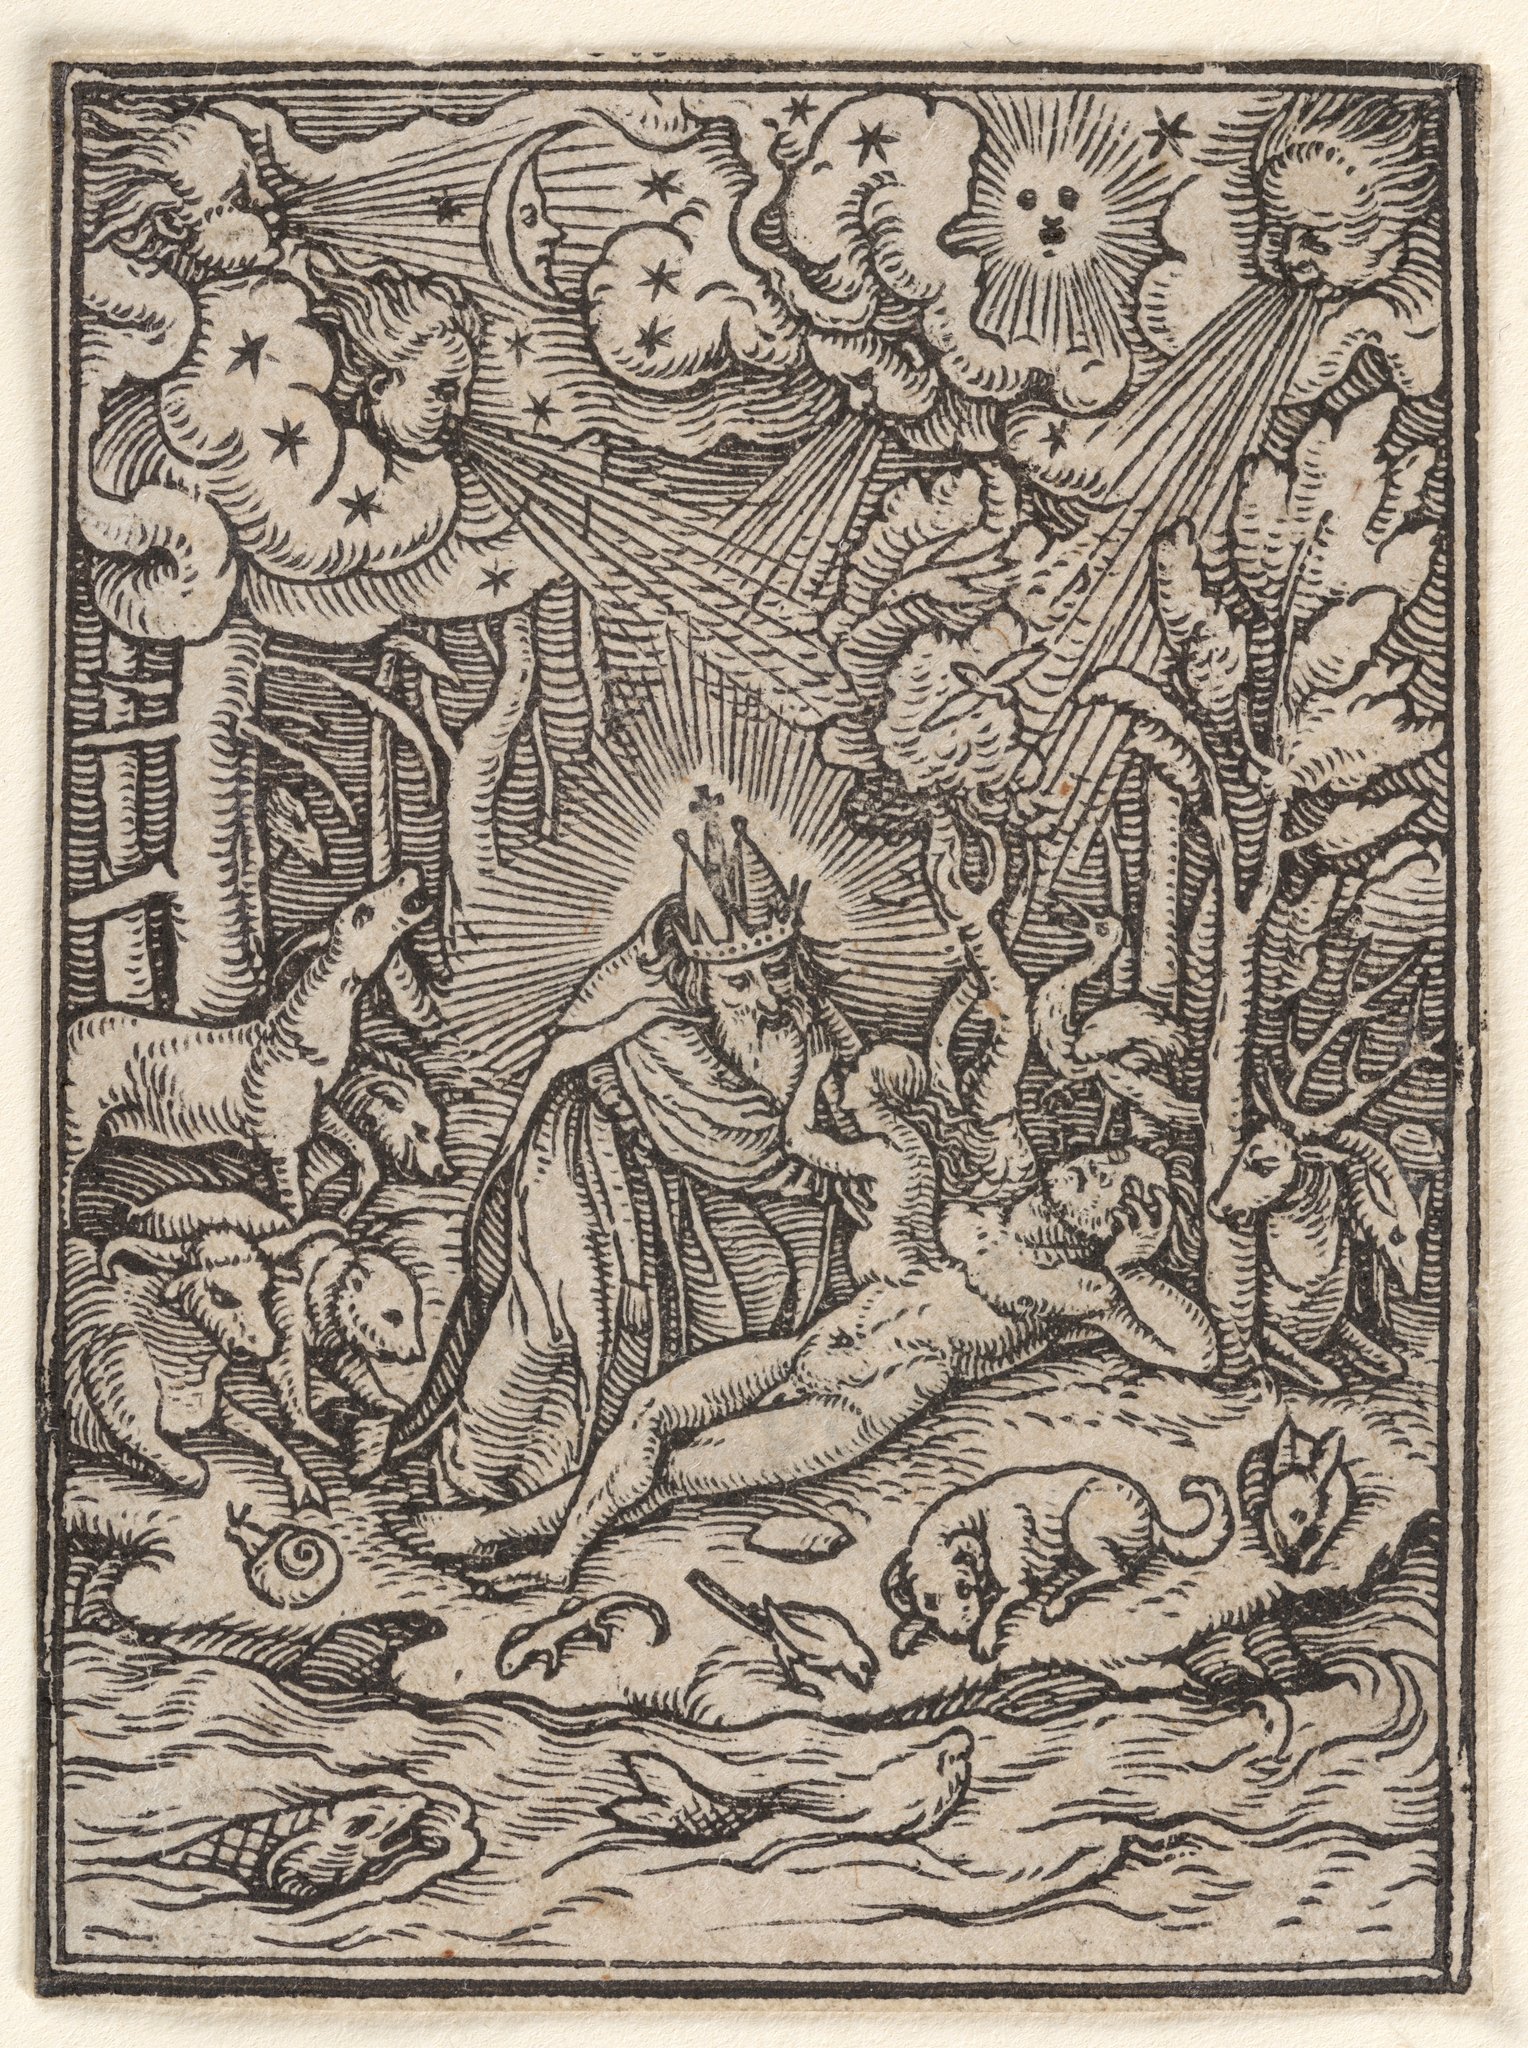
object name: print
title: Creation of Eve, from "The Dance of Death"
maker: hans holbein the younger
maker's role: artist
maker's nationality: german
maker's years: 1497-1543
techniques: woodcut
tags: birds,boars,deer,dogs,fish,rabbits,moon,sun,gods,adam,eve,ox